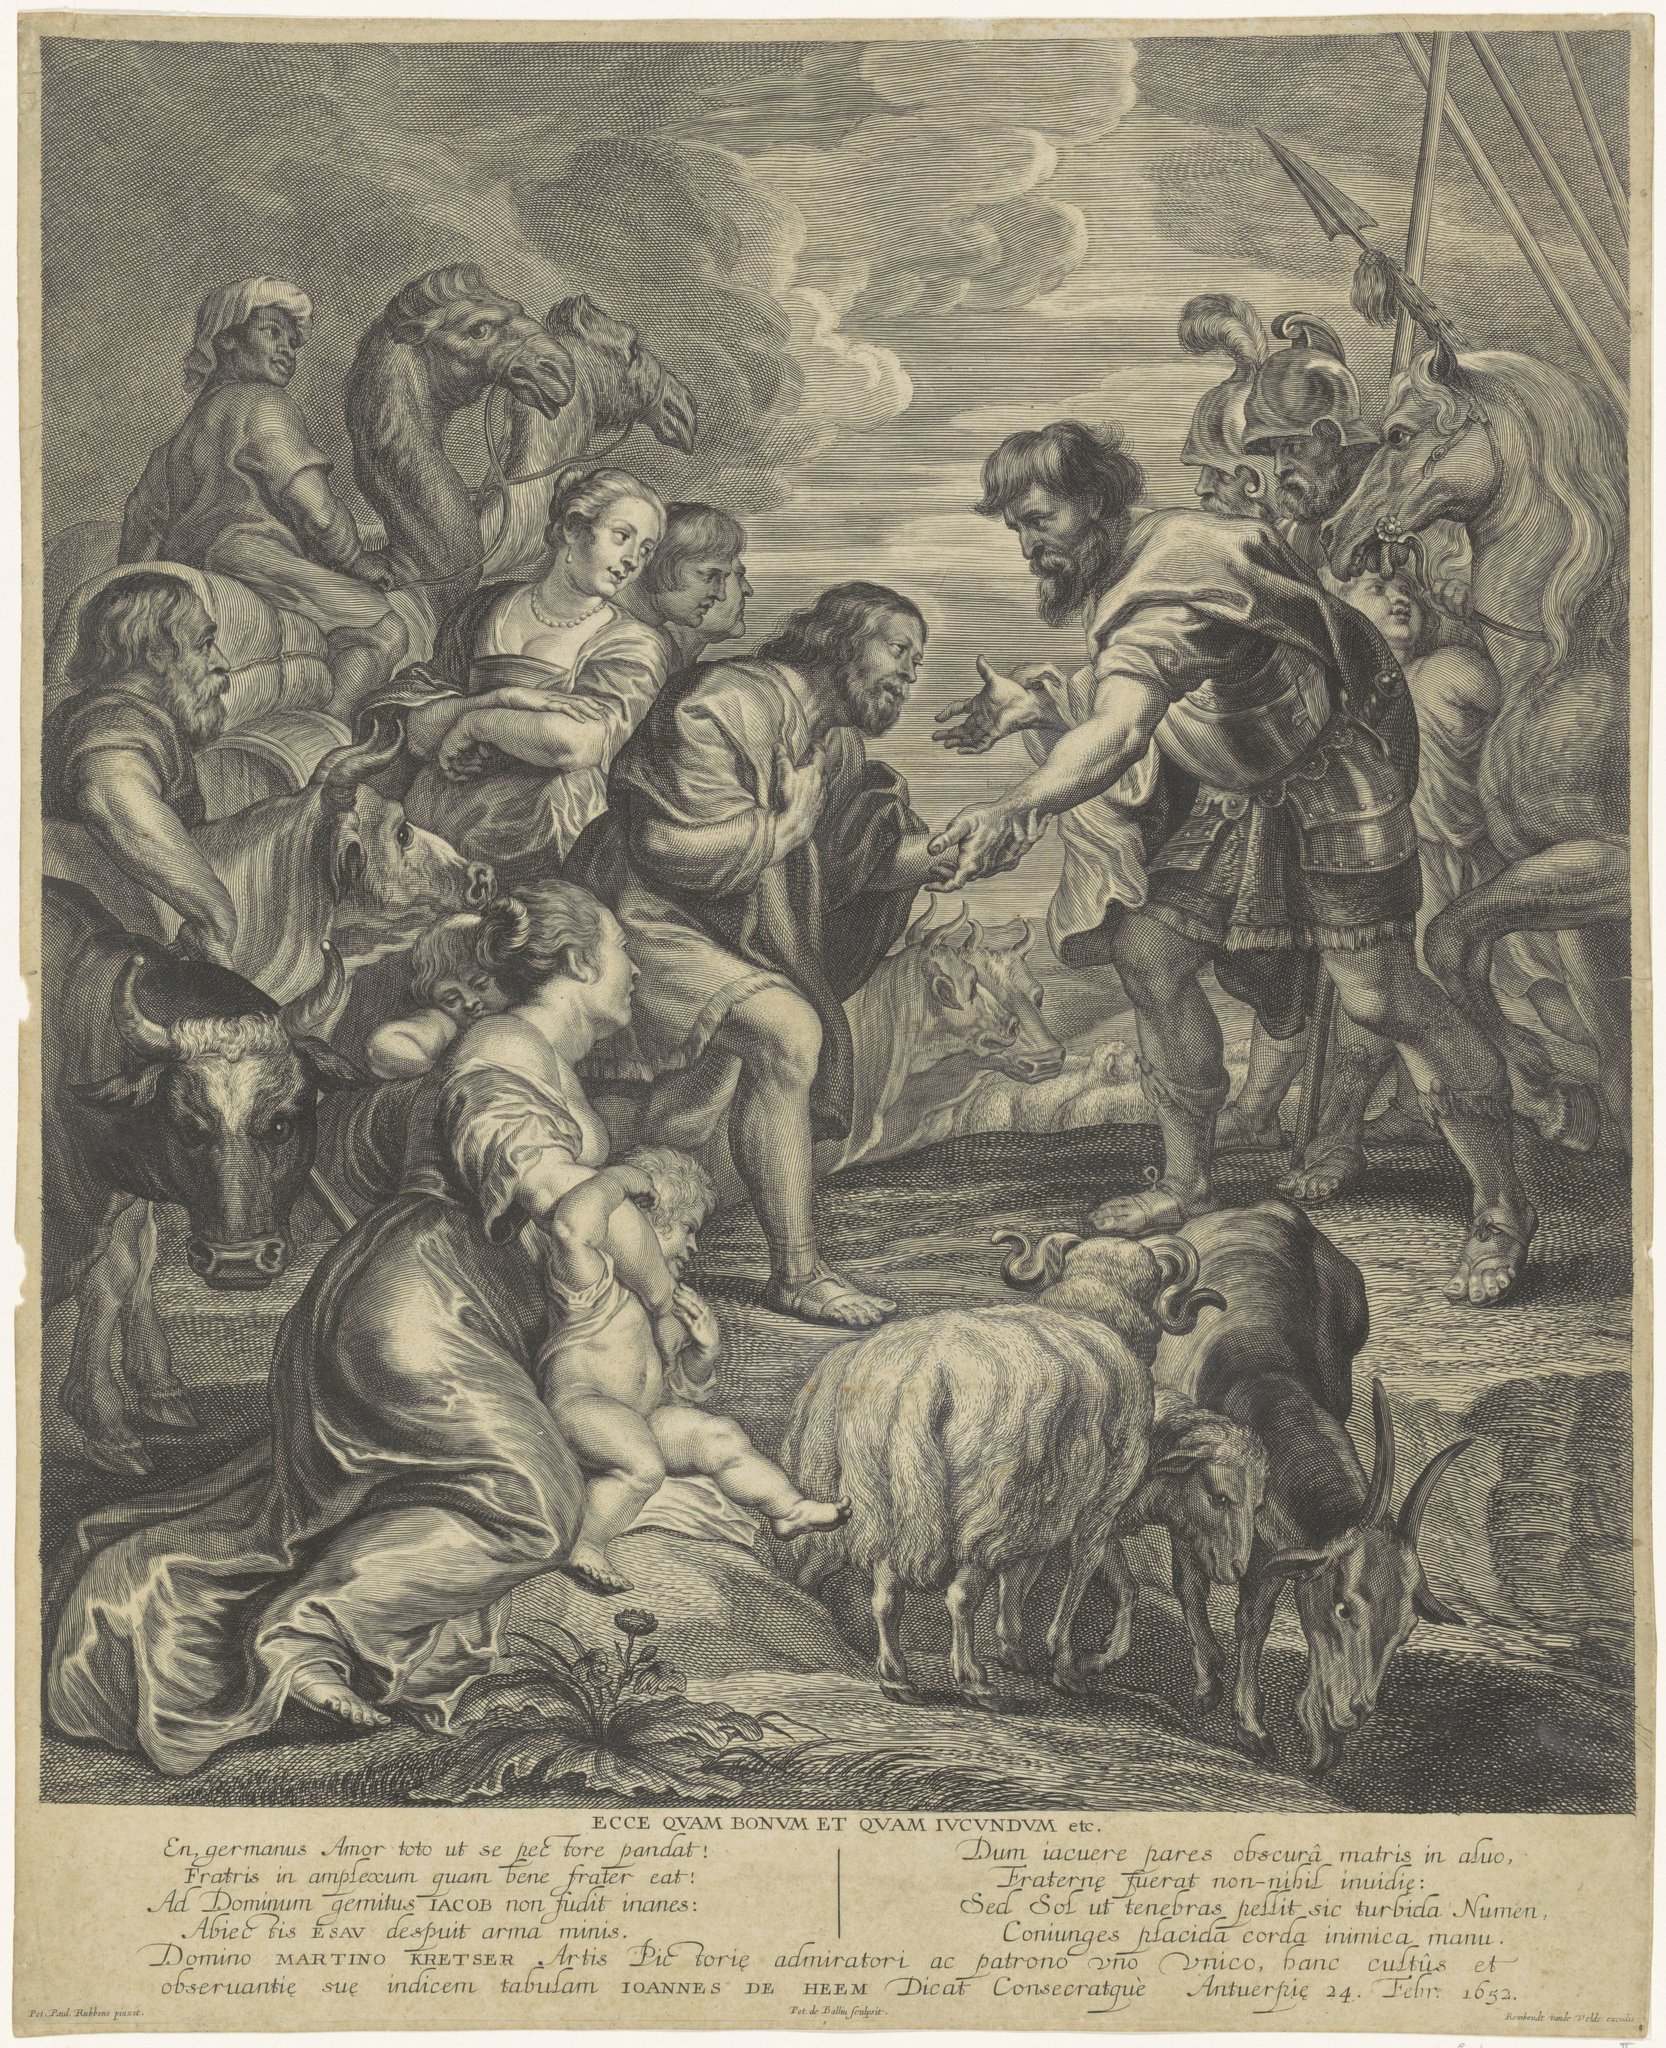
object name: print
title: Verzoening van Jakob en Esau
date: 1652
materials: paper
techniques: engraving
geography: antwerp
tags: the meeting between esau and jacob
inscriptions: collector's mark: Lugt 11, collector's mark: Lugt 10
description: De broers Jakob en Esau vallen elkaar in de armen. Rechts, achter Esau staat zijn leger. Links de geknielde vrouwen, kinderen en knechten van Jakob. Onder de voorstelling staan twee coupletten in het Latijn.